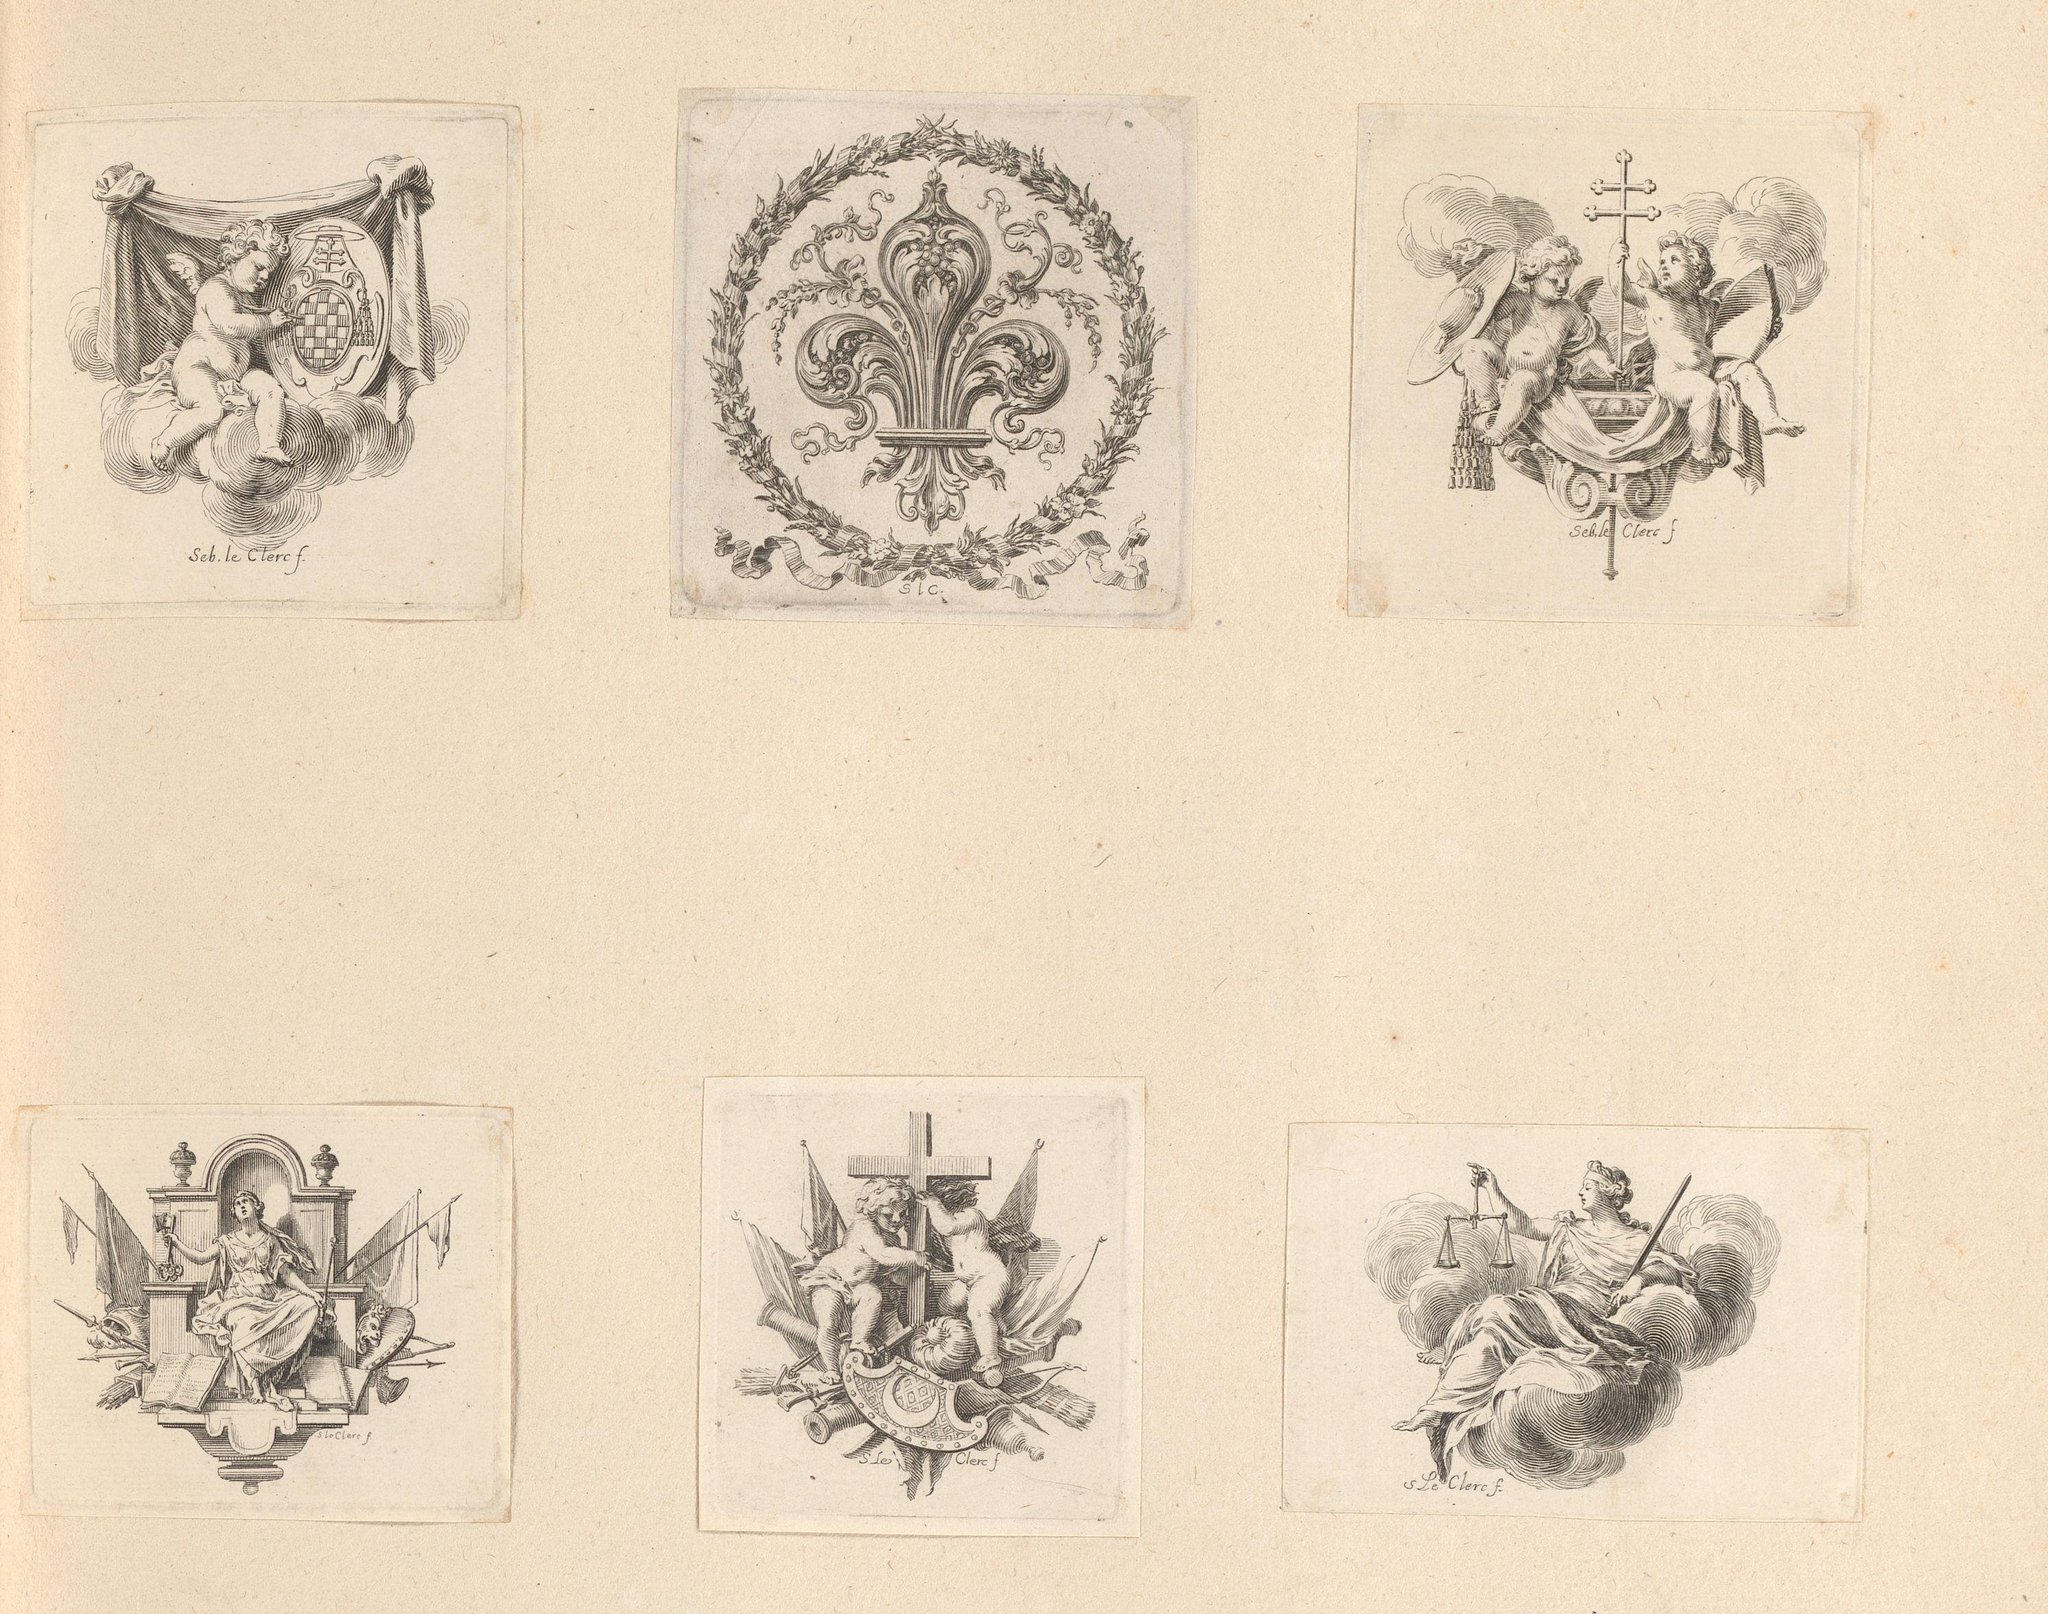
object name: print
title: Zes prenten uit: Esprit Fléchier's 'Histoire du cardinal Ximenés'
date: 1693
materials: paper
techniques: etching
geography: paris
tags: justitia (justice) as roman personification, cupids: 'amores', 'amoretti', 'putti'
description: Deze zes prenten bestaande uit vijf cul-de-lampes en het merk van de uitgever Anisson, maken deel uit van een album.